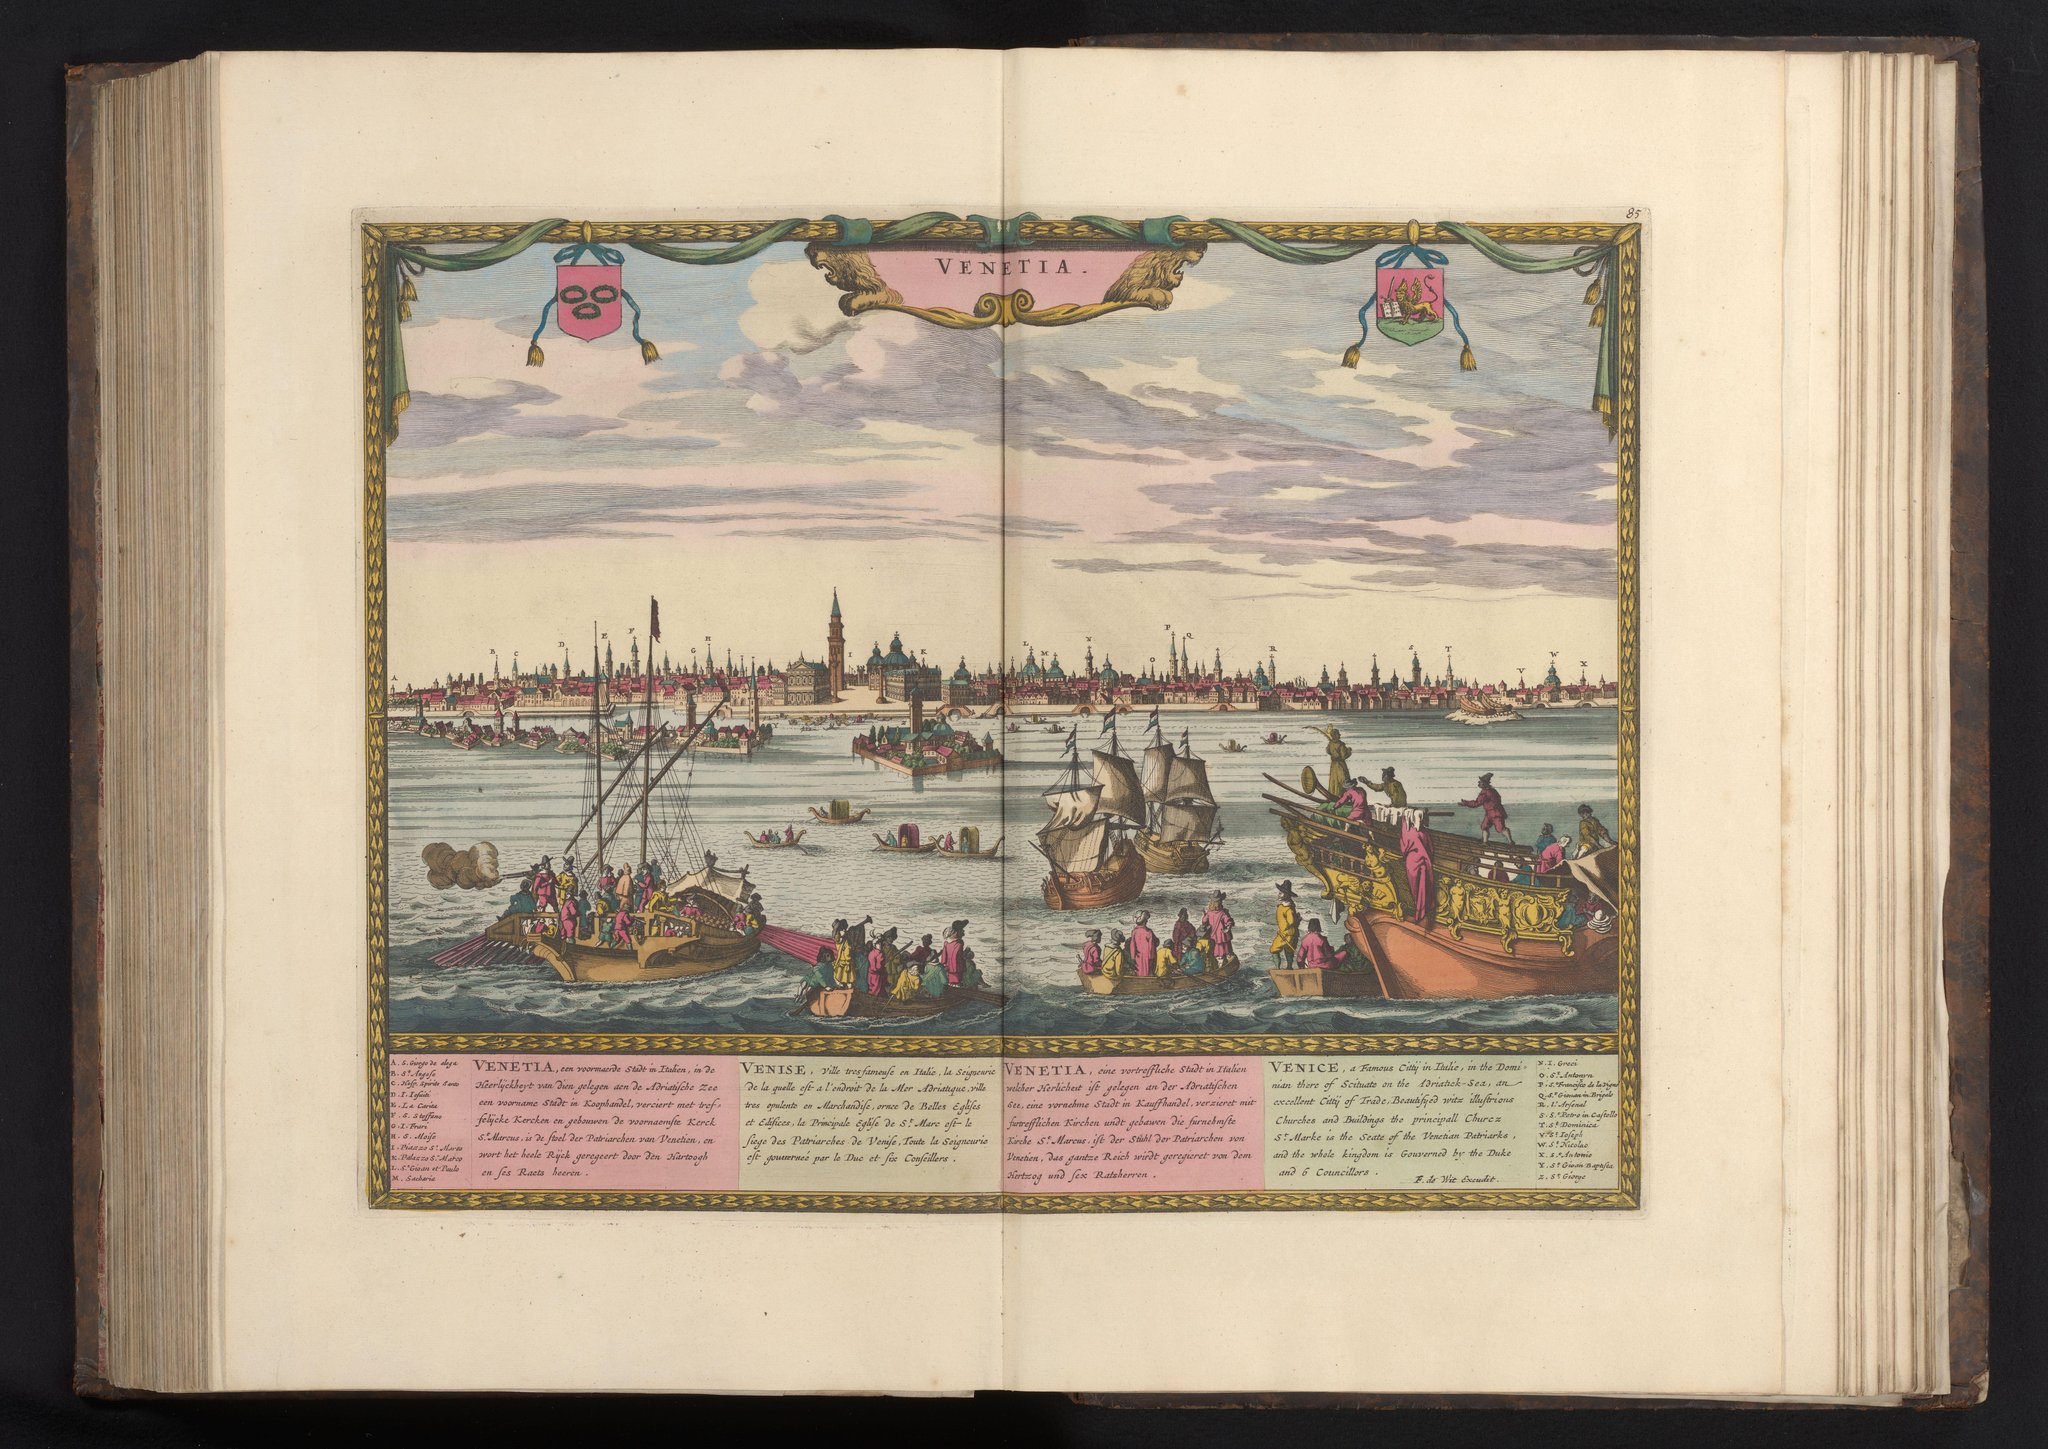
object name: print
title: Venetia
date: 1639-1706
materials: paper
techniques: colour, etching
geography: amsterdam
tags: city-view, and landscape with man-made constructions, maps of cities, venice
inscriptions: number: ‘85’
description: Gezicht op de laguna te Venetië. Onderschift in het Nederlands, Frans, Duits en Engels. Prent maakt deel uit van een album.